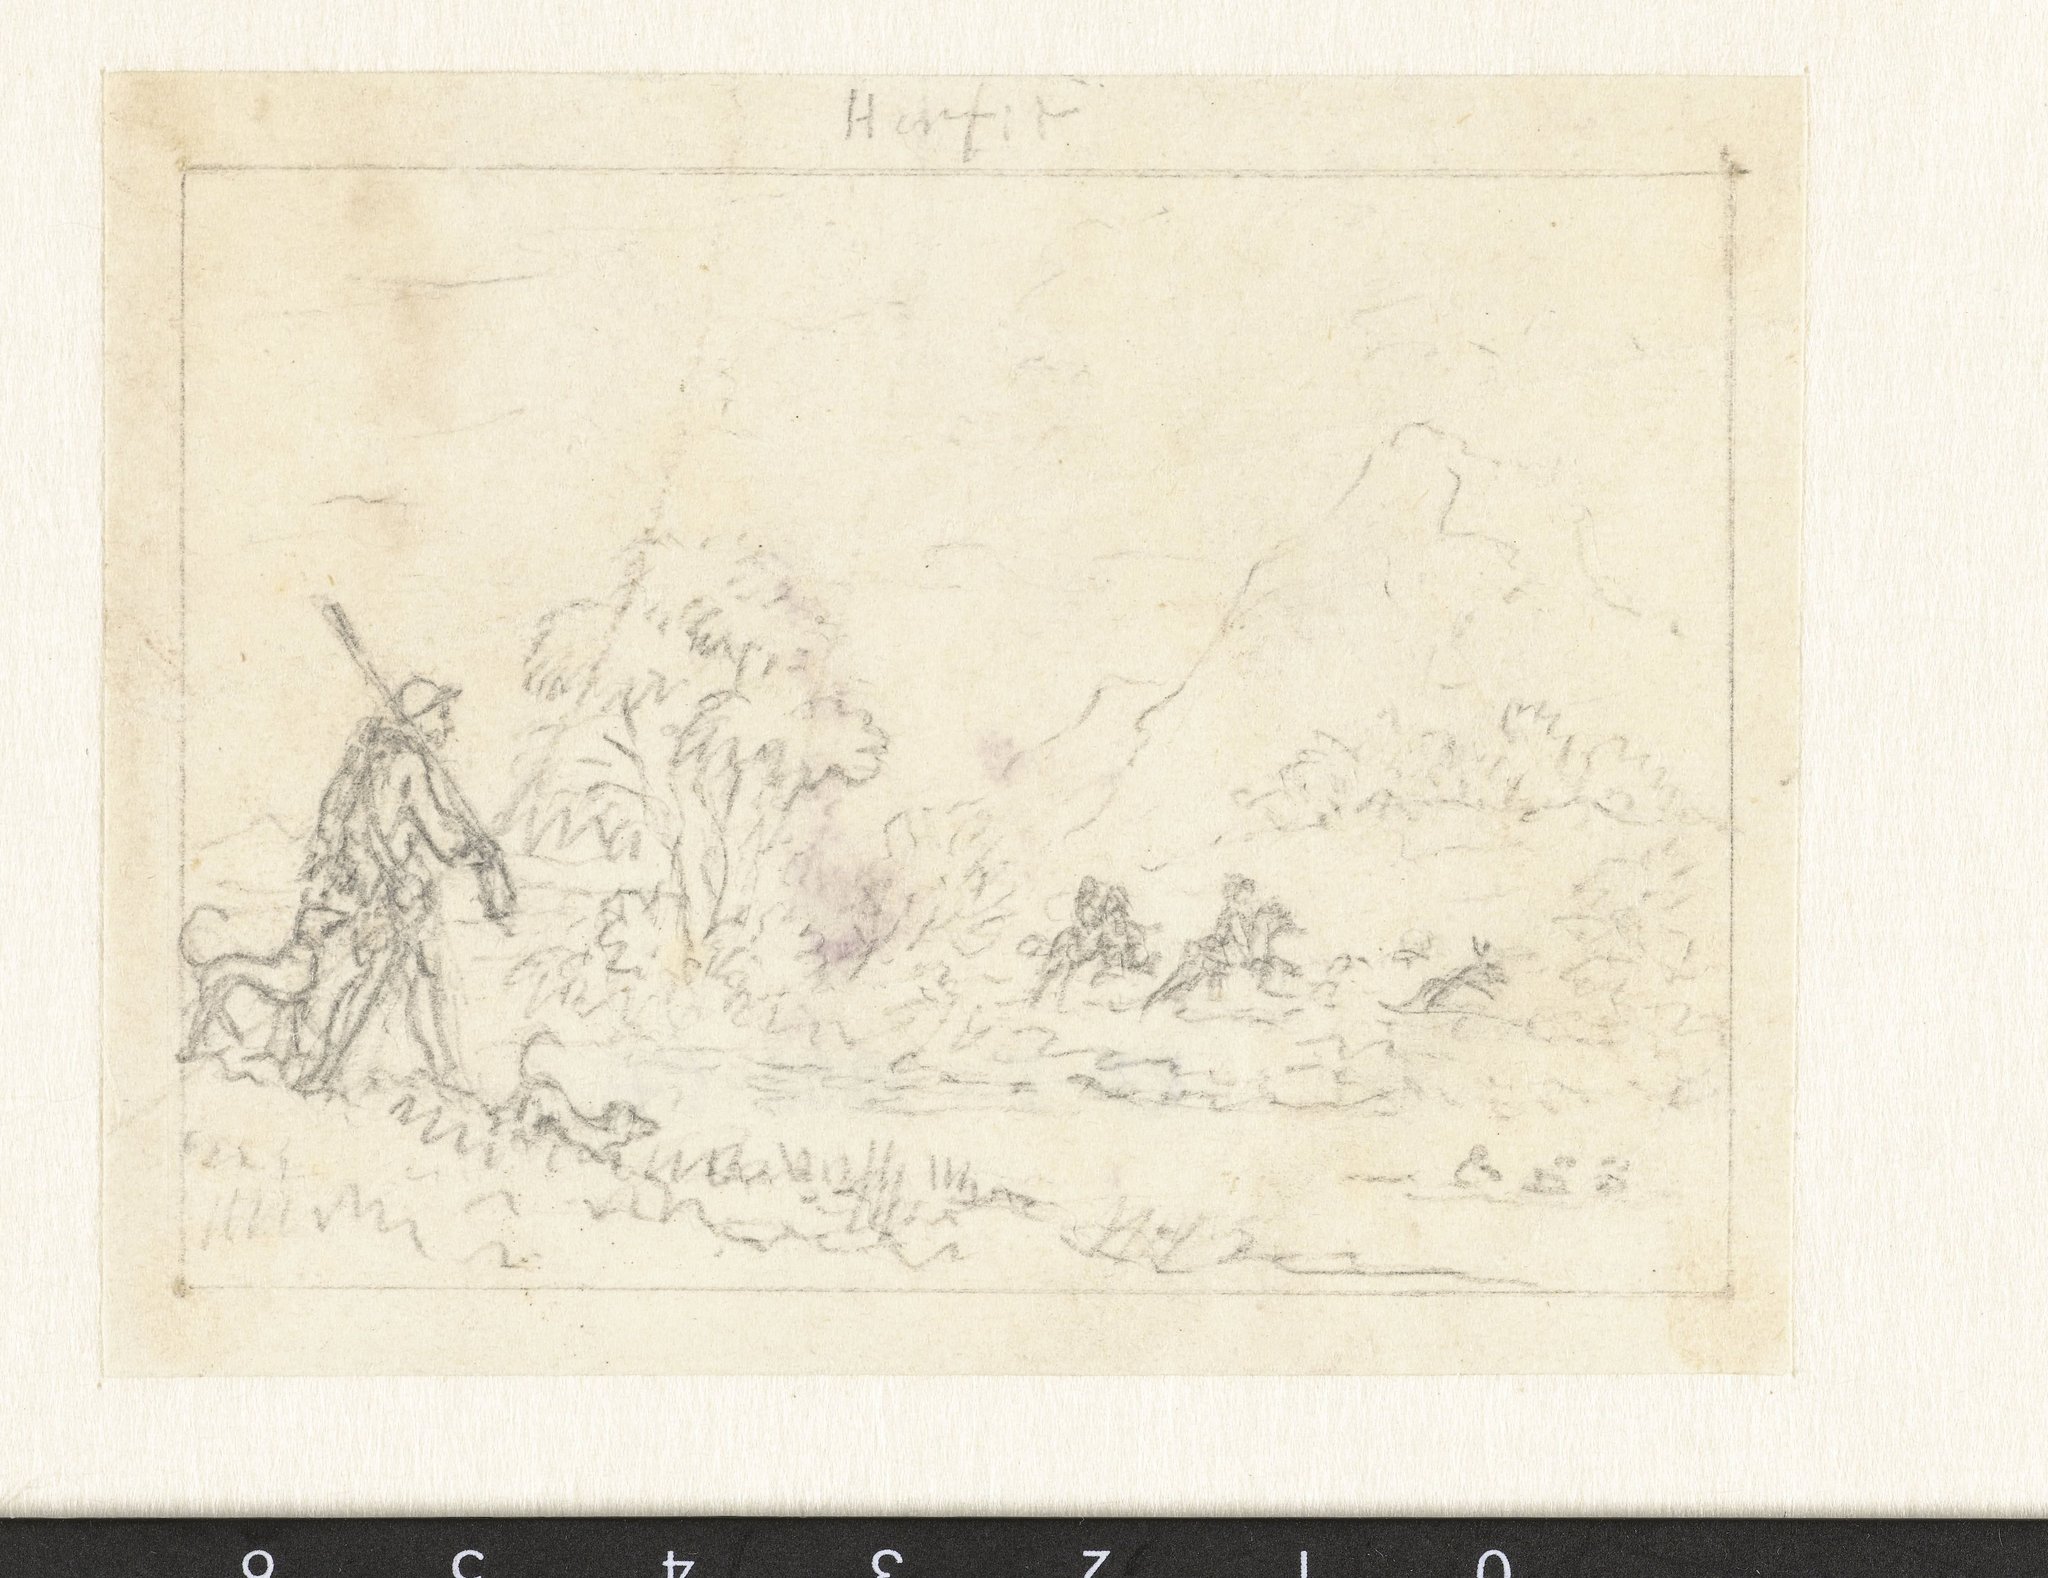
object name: drawing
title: Herfst: afbeelding van de jacht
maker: simon fokke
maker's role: draughtsman, print maker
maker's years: 1712-1784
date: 1722-1784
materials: paper, pencil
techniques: pouncing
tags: autumn, fall, 'autumnus'; 'autunno' (ripa)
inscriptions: annotation: ‘Herst’